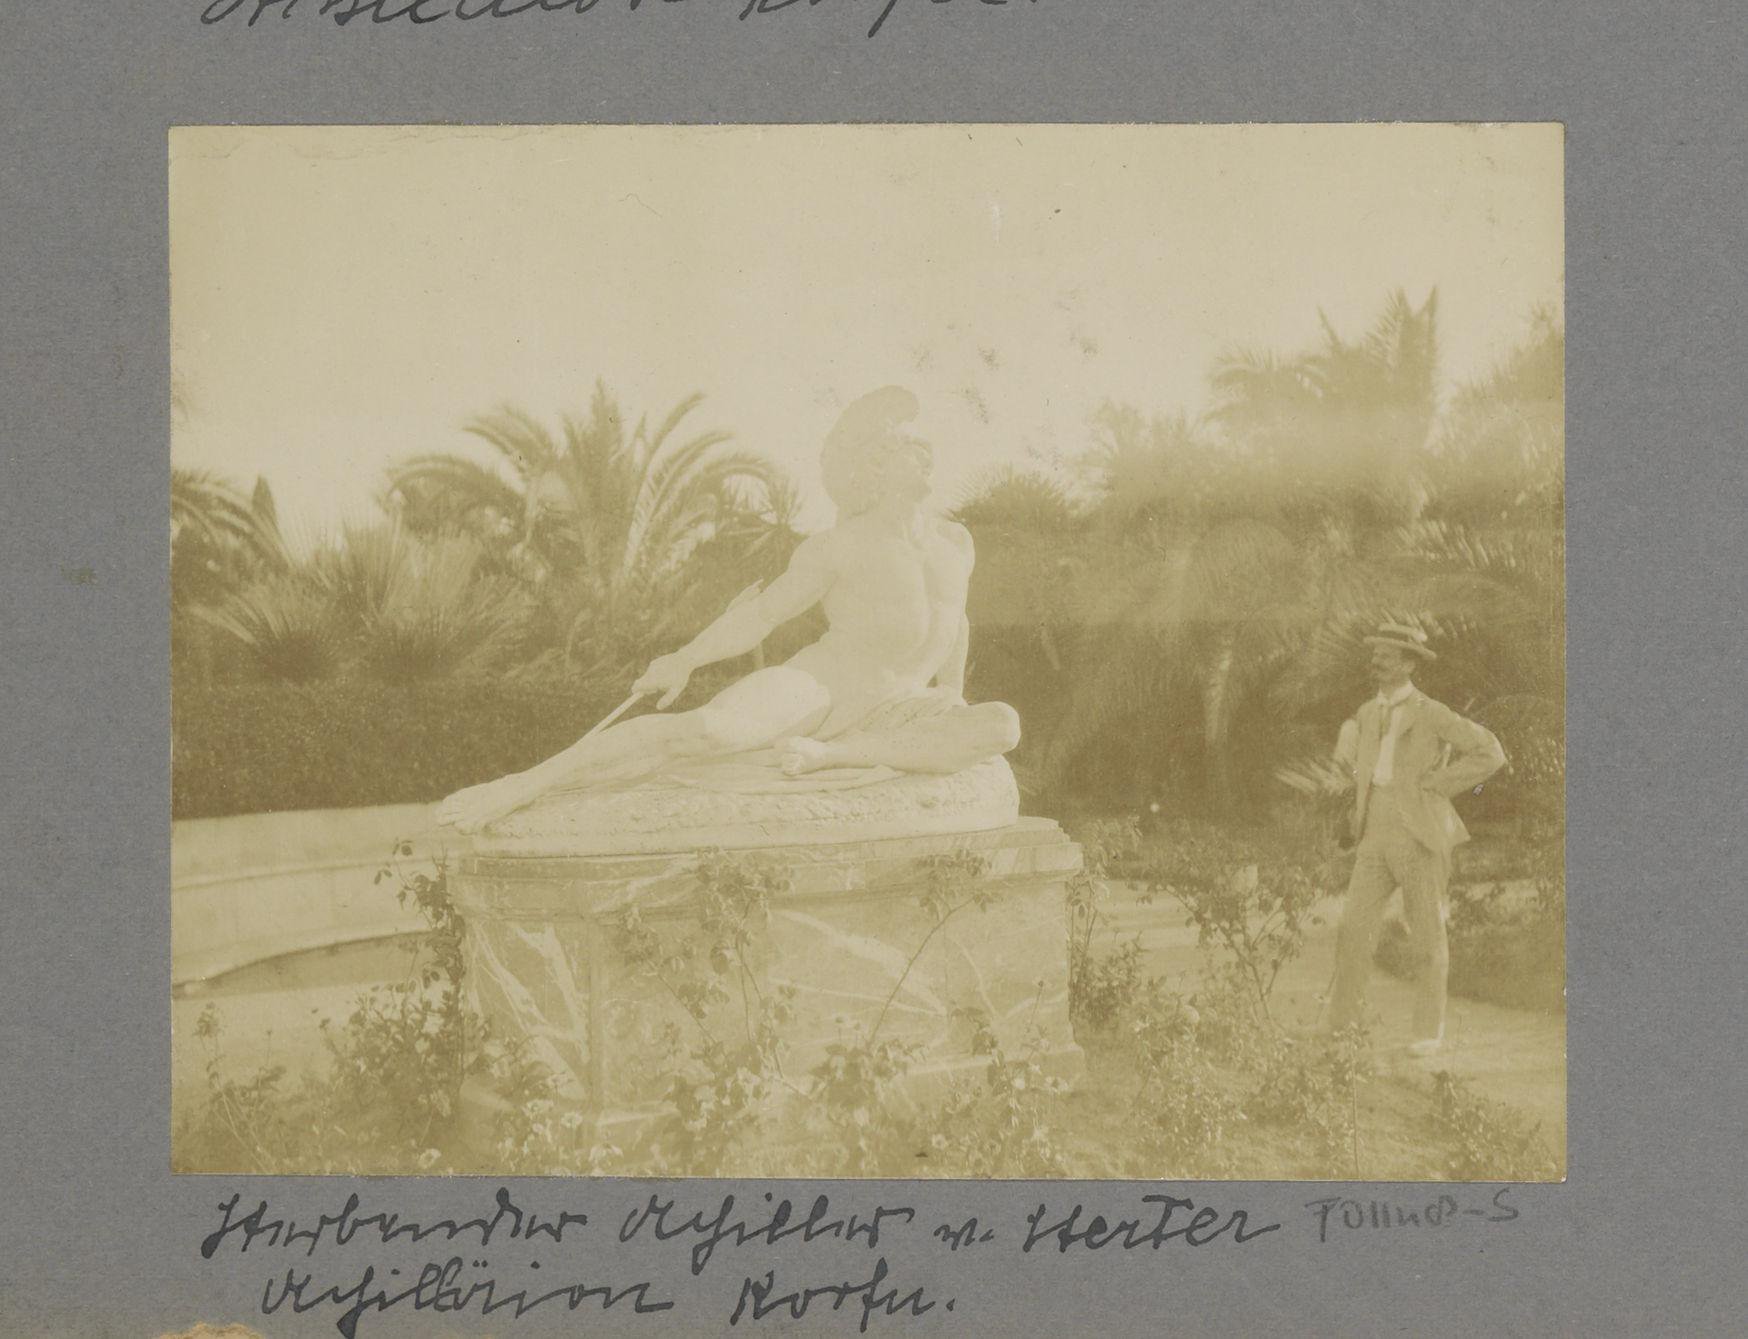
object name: album leaf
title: Man staand naast het beeld van Achilles bij het Achilleion op Corfu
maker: Anonymous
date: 1905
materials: paper, photographic support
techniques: gelatin silver print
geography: corfu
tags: piece of sculpture, reproduction of a piece of sculpture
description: Onderdeel van Reisalbum met foto's van bezienswaardigheden in Griekenland en Egypte.